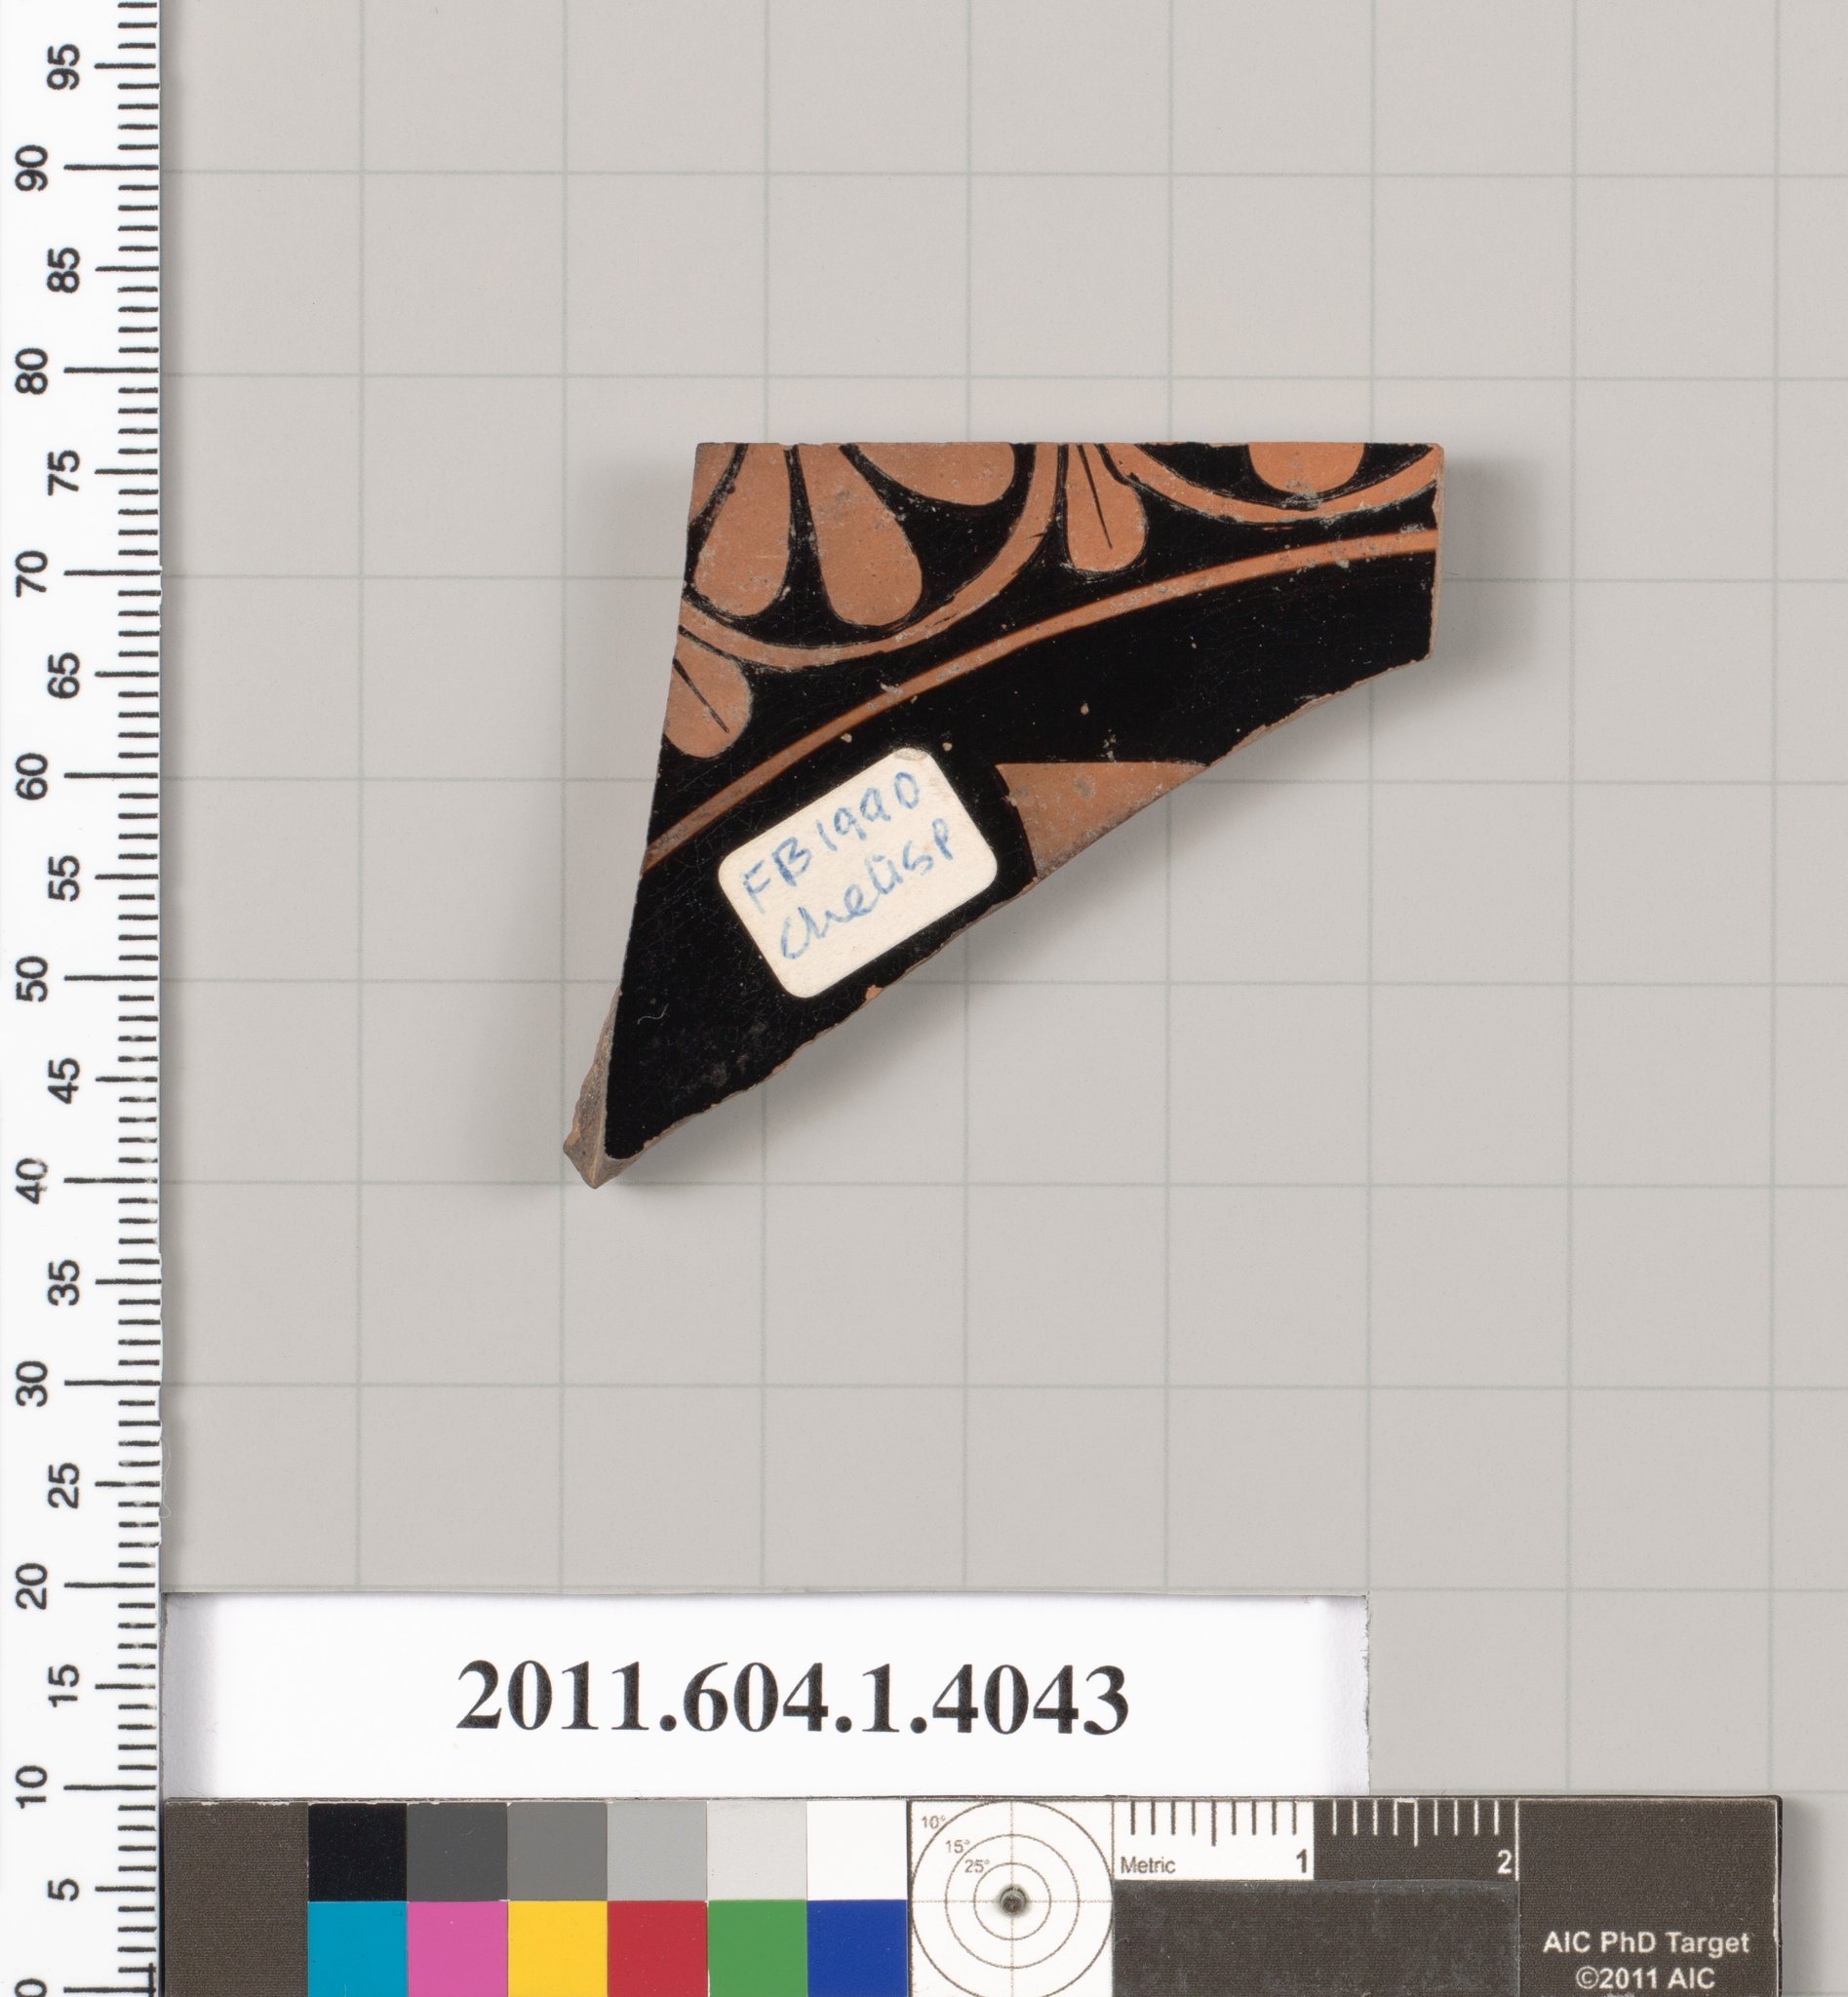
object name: kylix fragment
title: Terracotta fragment of a kylix (drinking cup)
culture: greek, attic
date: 534-468 BCE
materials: terracotta